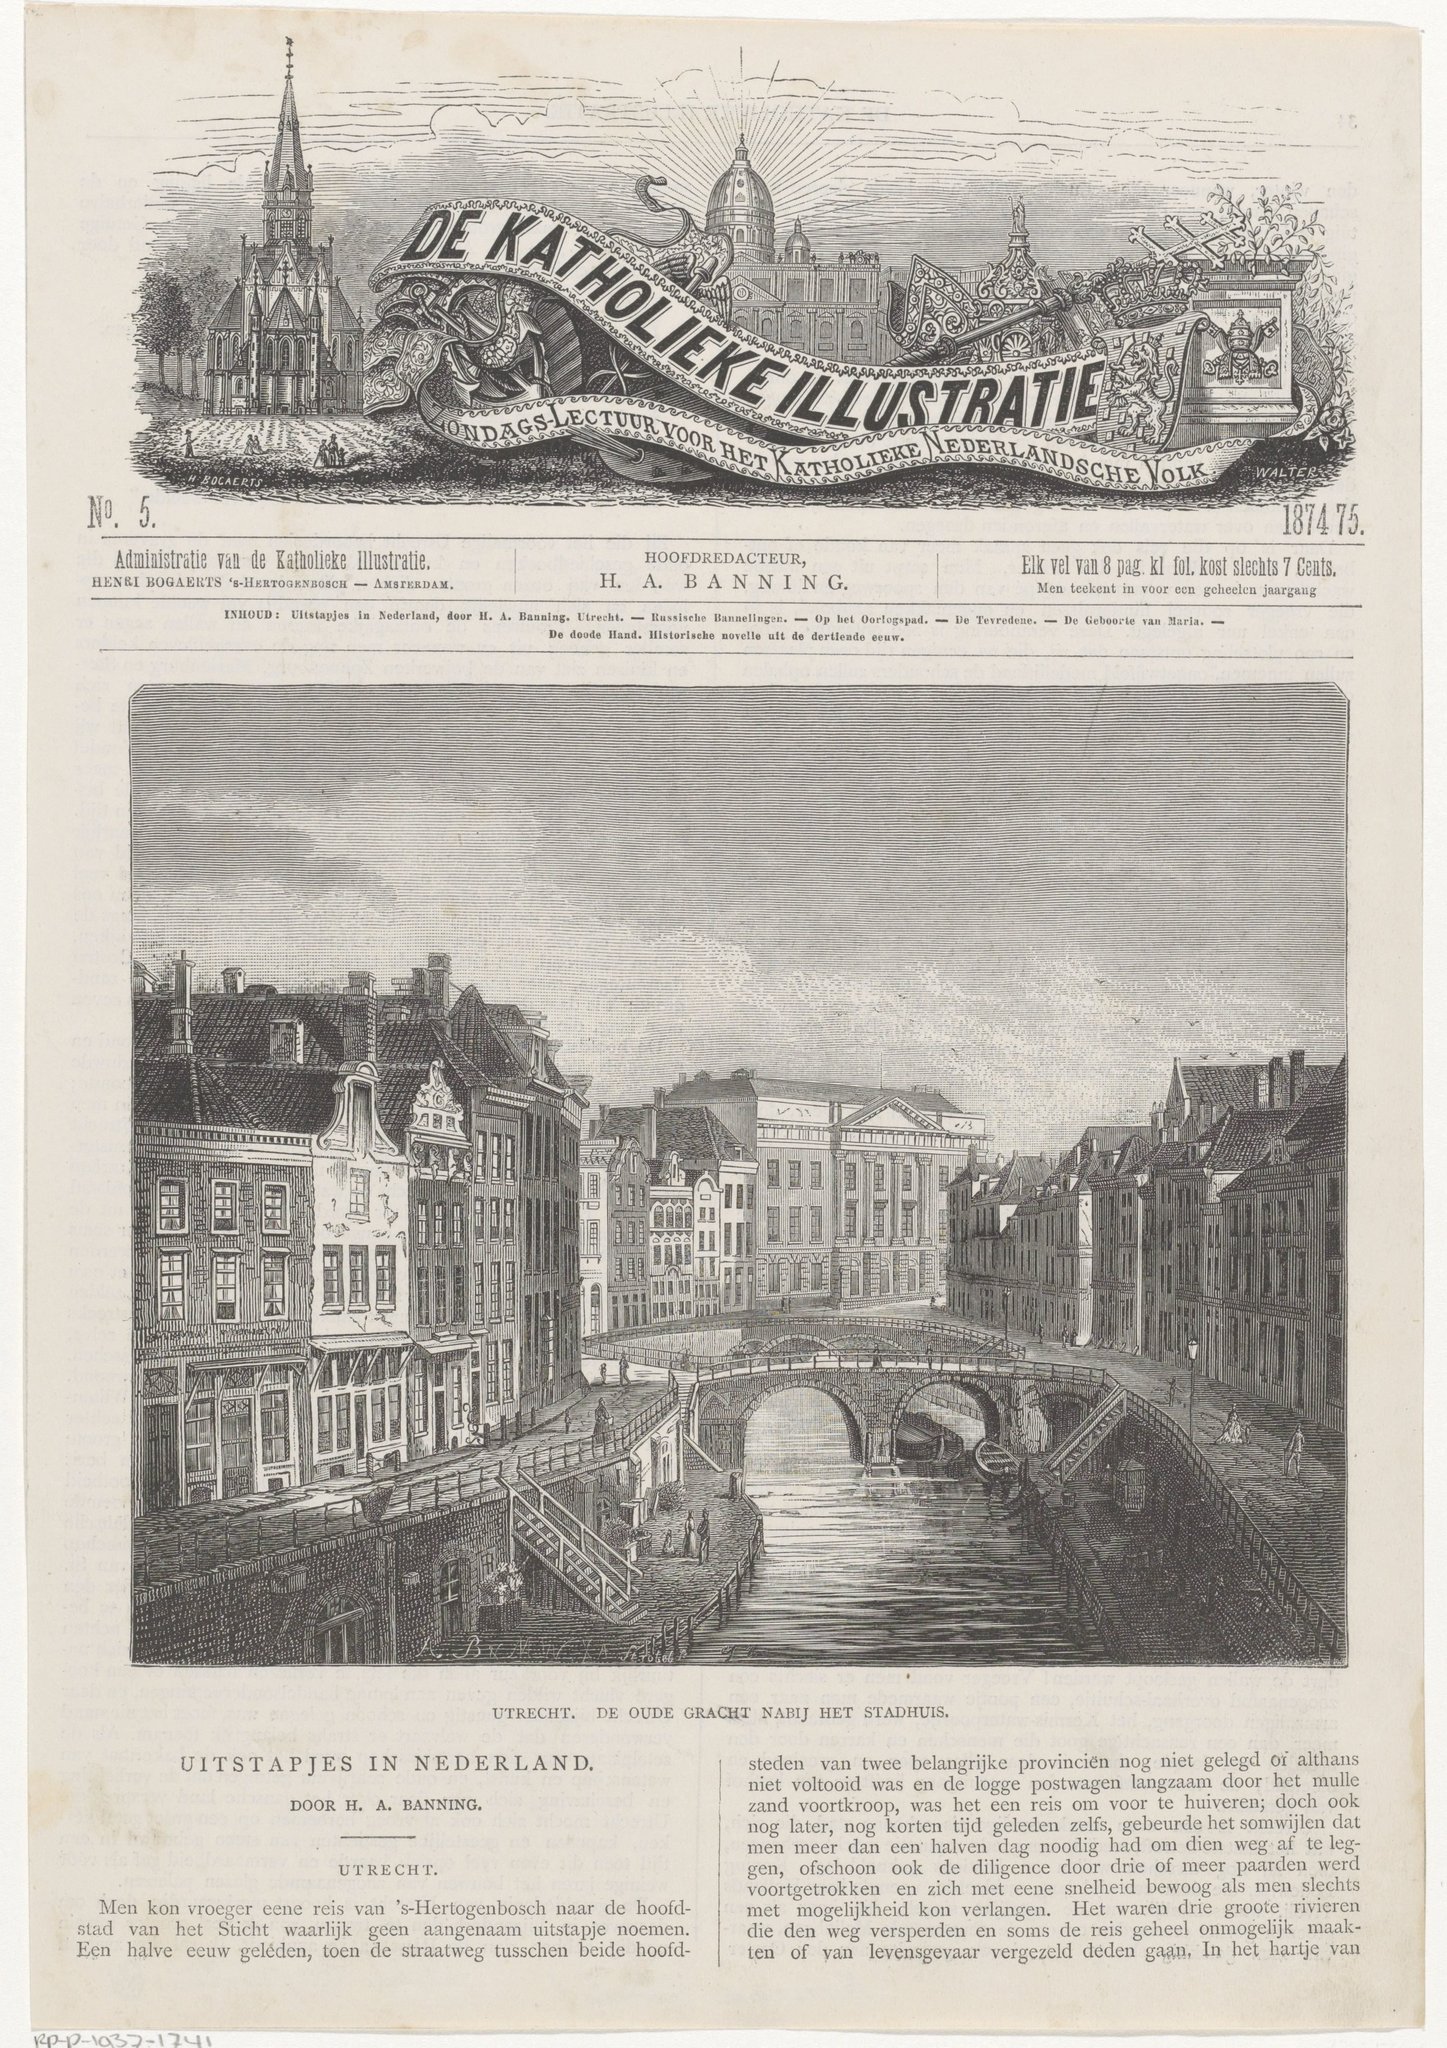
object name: print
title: Utrecht. De Oude Gracht nabij het stadhuis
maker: konrad strobel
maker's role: print maker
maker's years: 1849-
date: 1874-1875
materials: paper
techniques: letterpress printing, engraving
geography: netherlands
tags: street (+ city(-scape) with figures, staffage)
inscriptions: collector's mark: Lugt 2760, collector's mark: Lugt 2228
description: Prent uit: De Katholieke illustratie. 1874-1875.